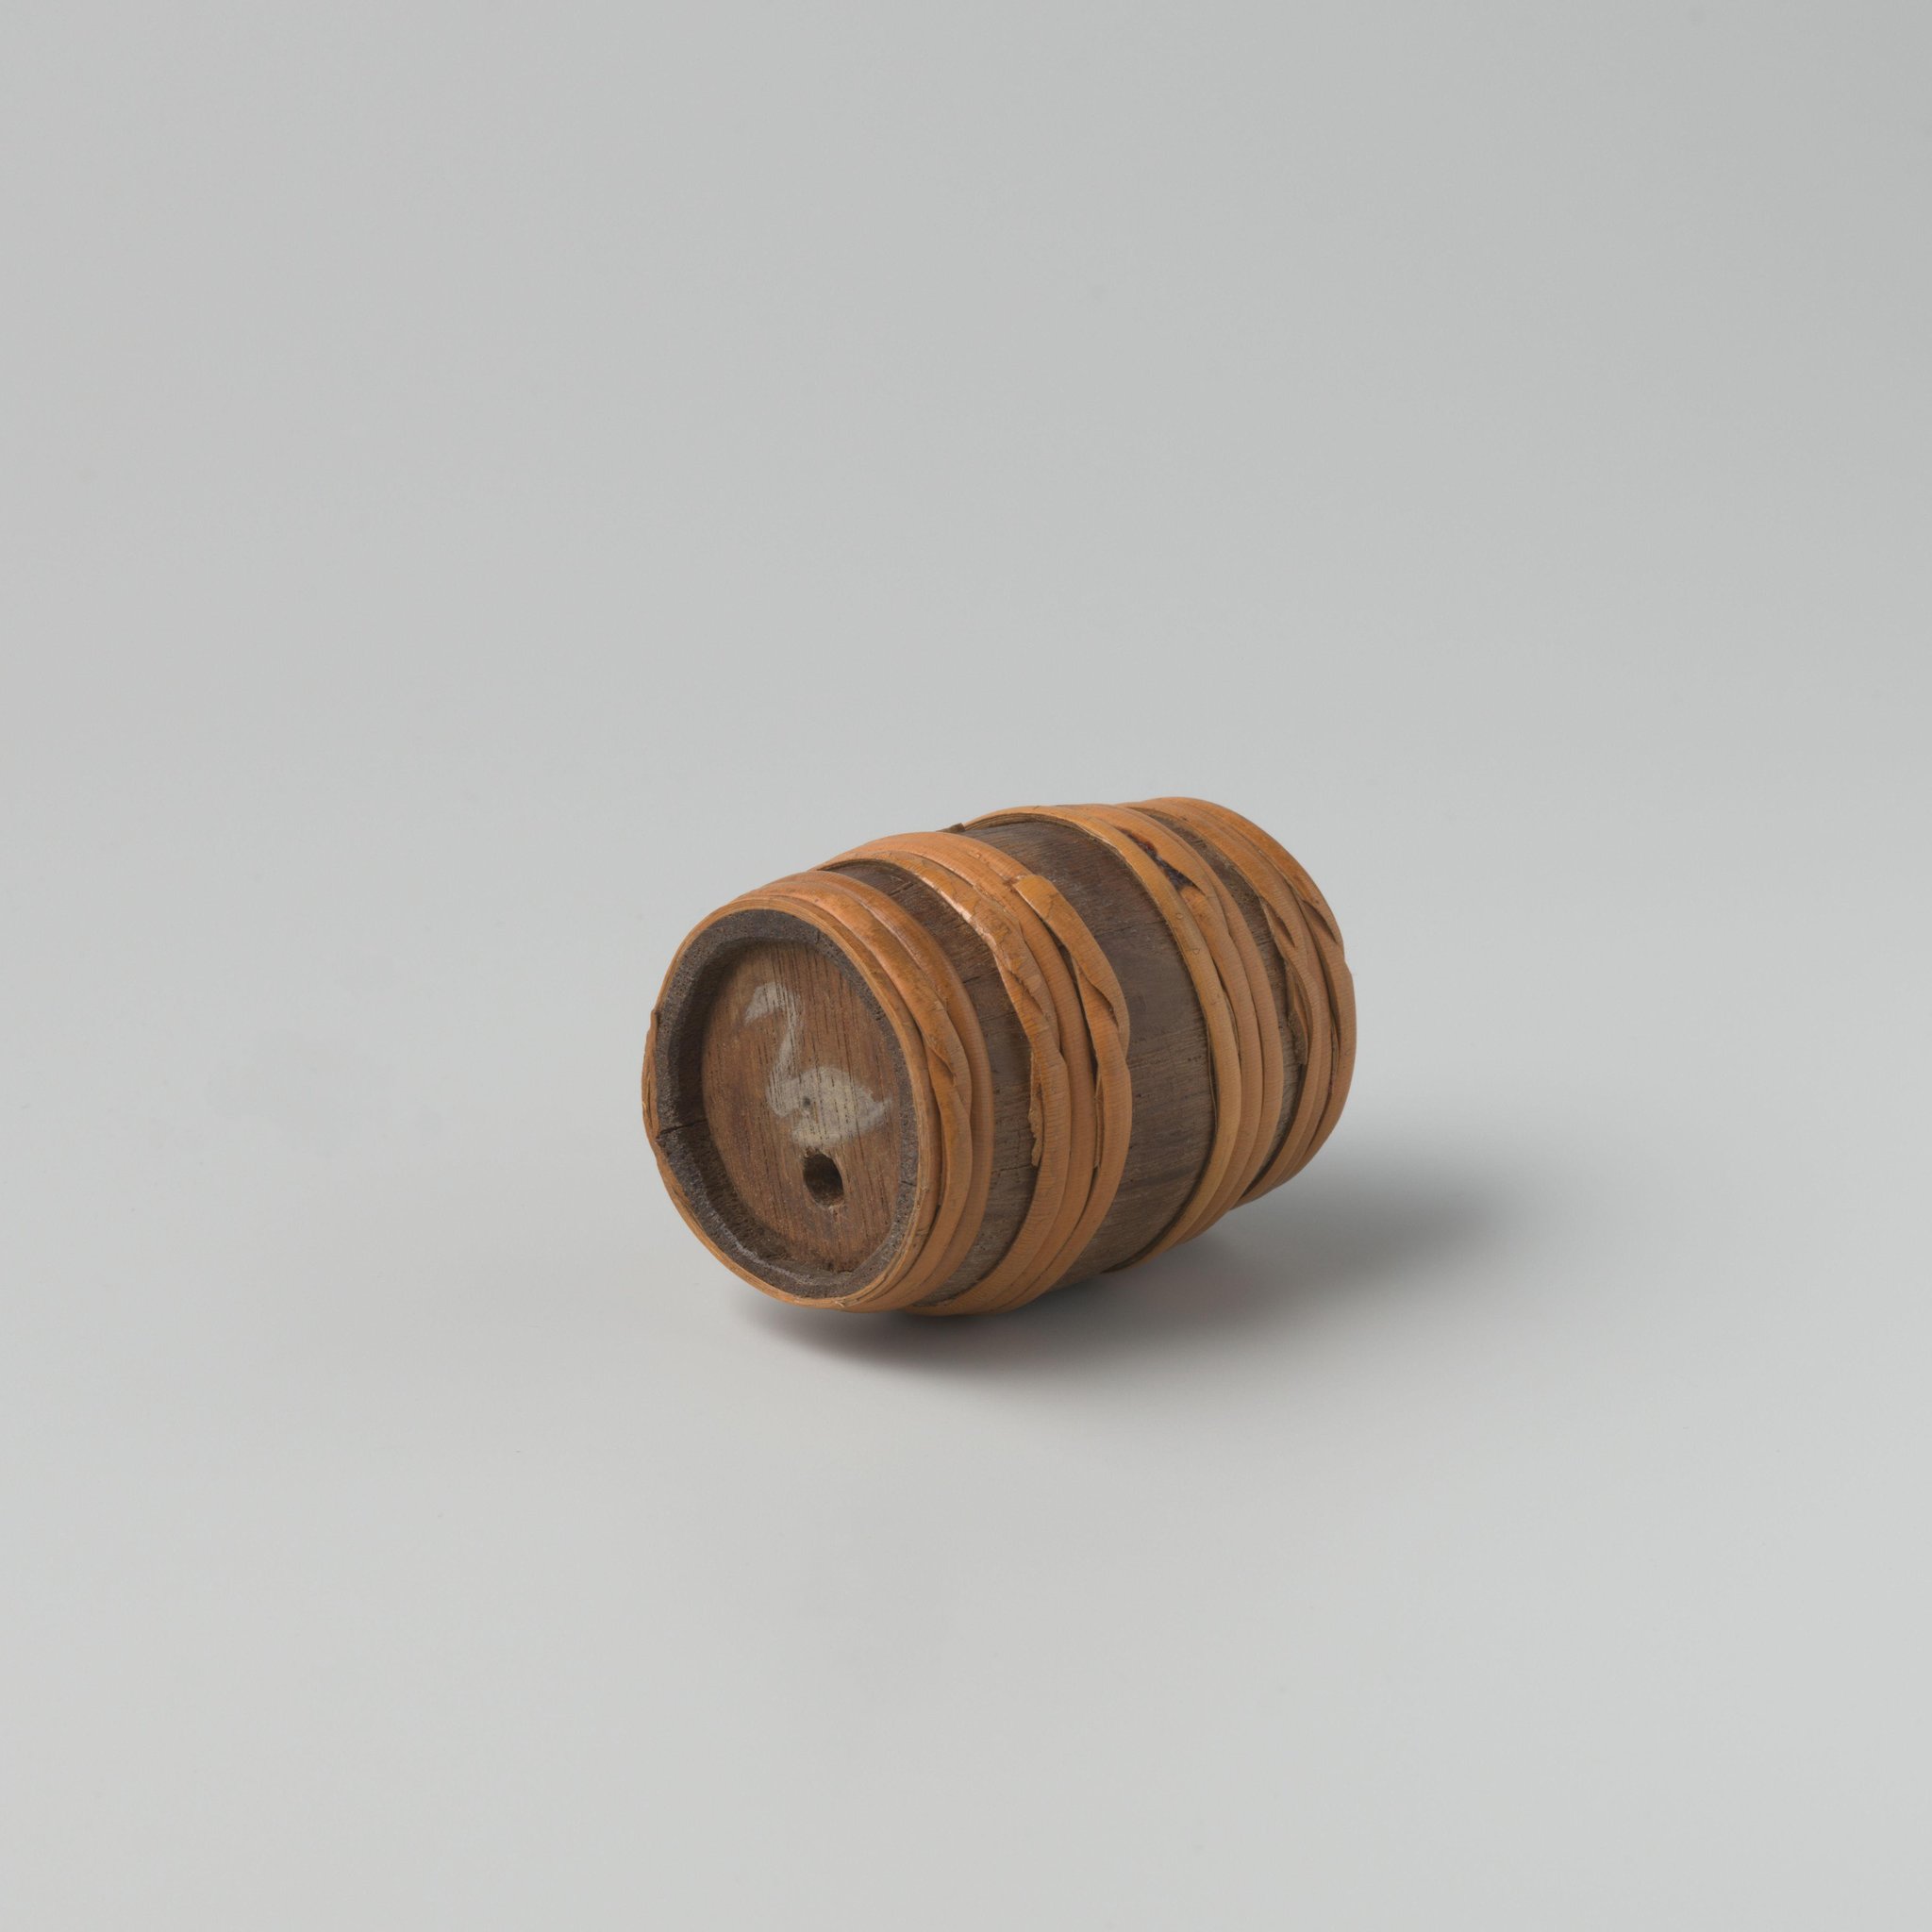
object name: wijnvat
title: Bier- of wijnvat, van eikenhouten duigen, omwonden door 4 x 3 hoepels van rotan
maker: Anonymous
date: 1690-1710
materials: brass, wood, rattan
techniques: gilding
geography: amsterdam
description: Bier- of wijnvat, van eikenhouten duigen, omwonden door 4 x 3 hoepels van rotan. Op de voorkant is met witte verf een zwaantje geschilderd.